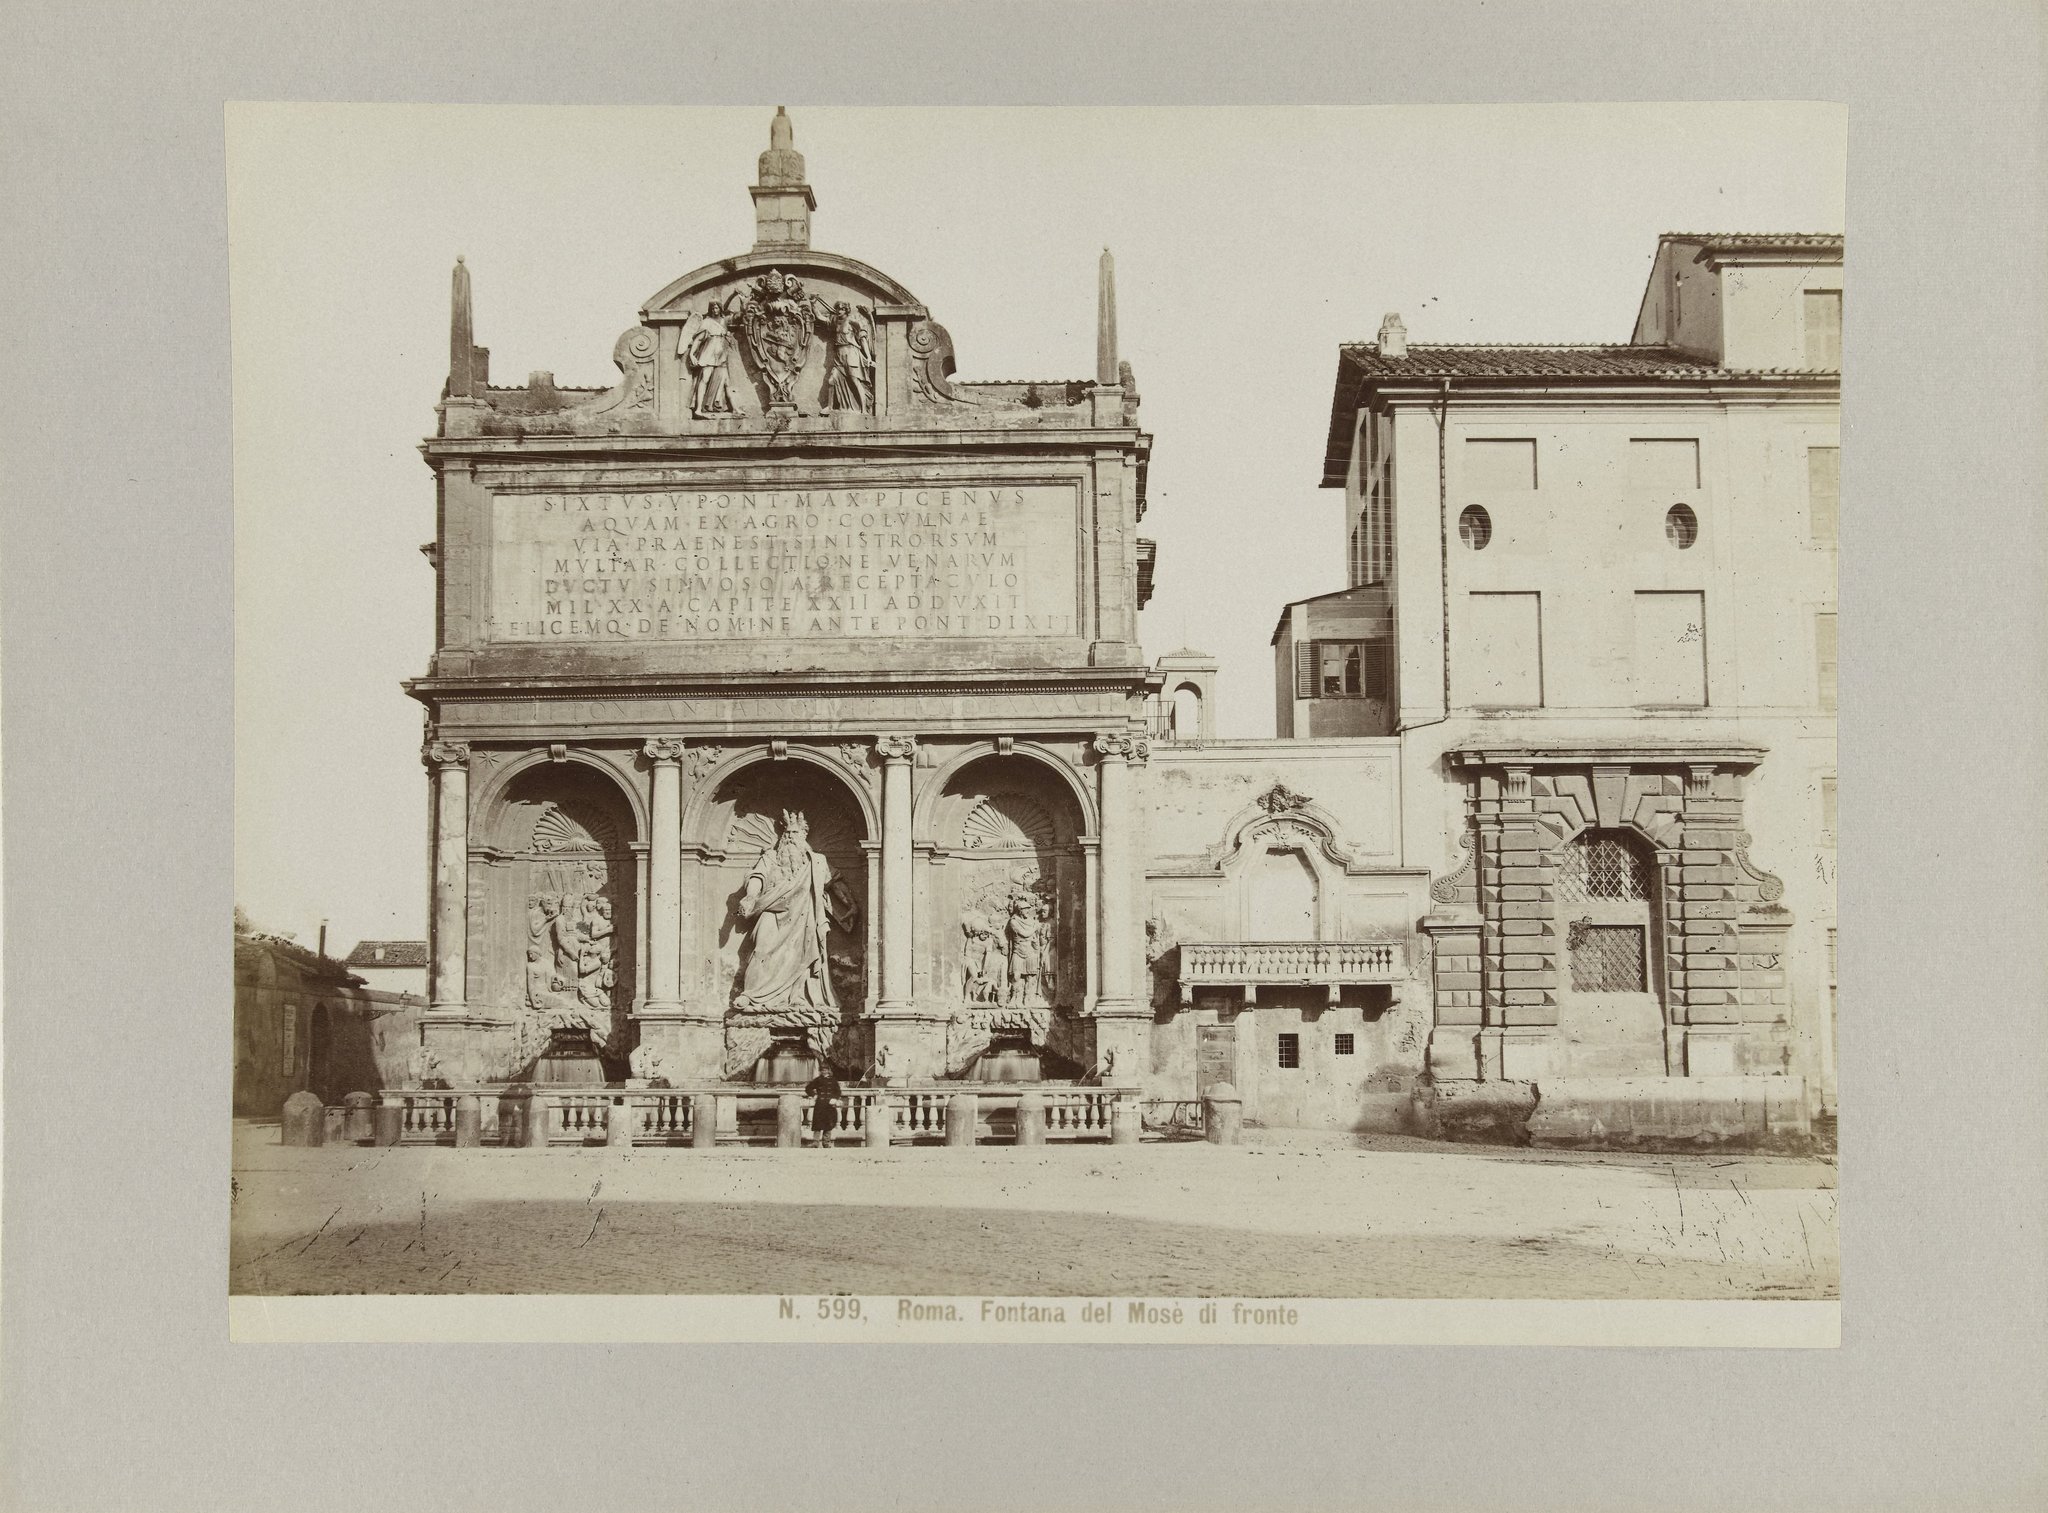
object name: photograph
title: N. 599, Roma. Fontana del Mosè di fronte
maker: Anonymous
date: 1880-1895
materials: cardboard, paper, photographic support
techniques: albumen print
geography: rome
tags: rome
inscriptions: number: ‘3.’